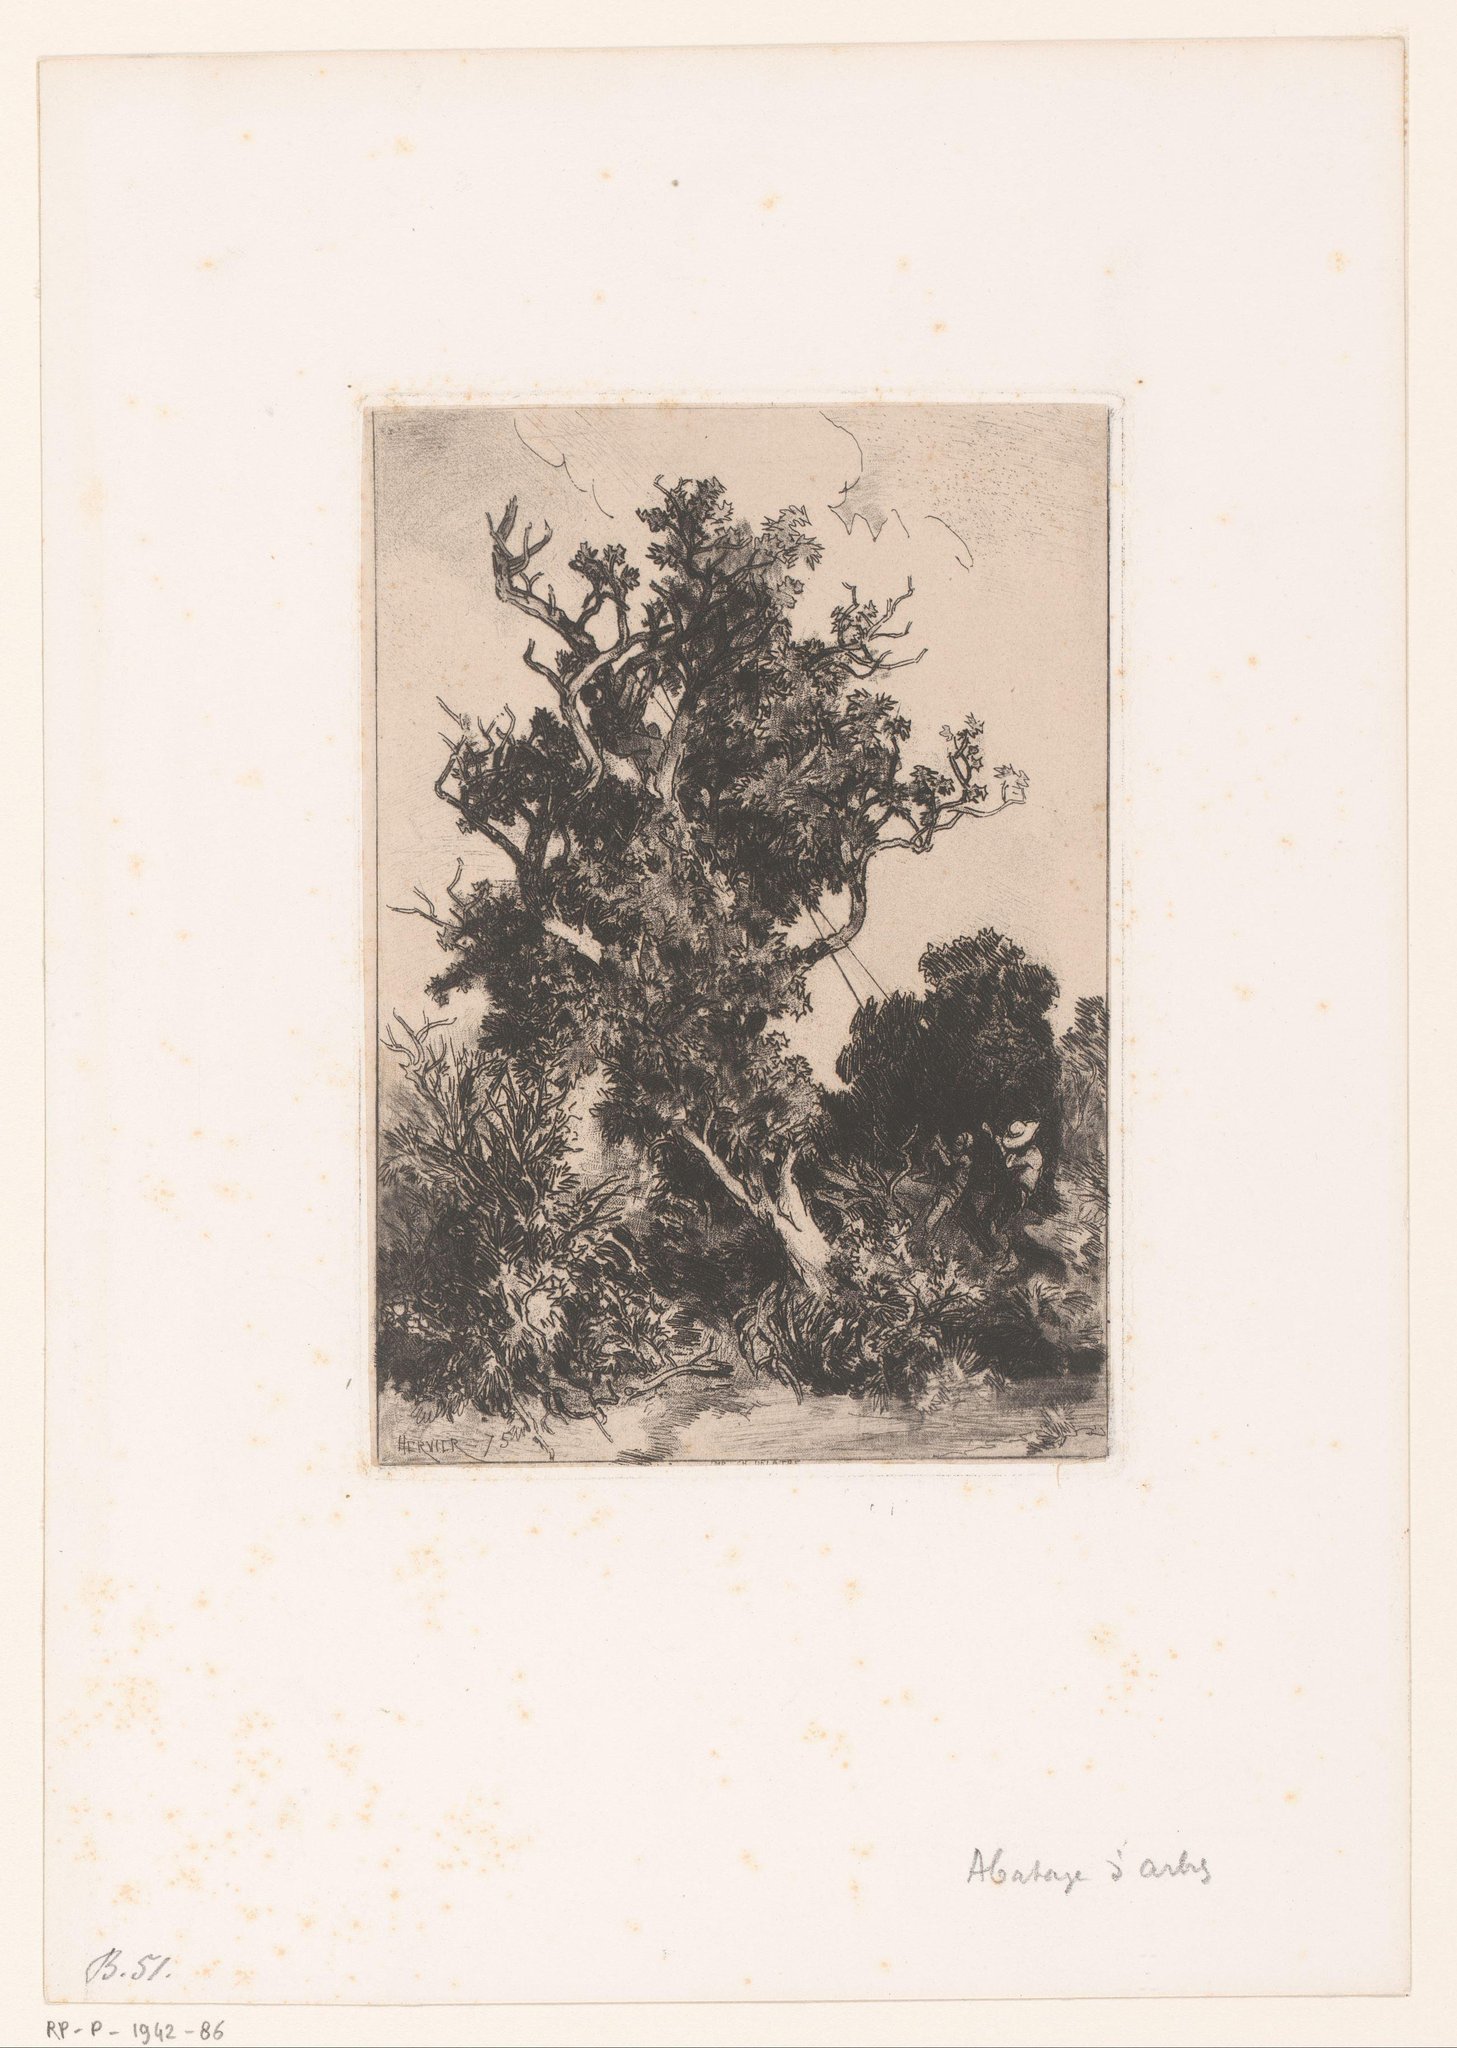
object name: print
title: 6 Eaux-fortes par Hervier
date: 1875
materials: paper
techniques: etching, roulette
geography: paris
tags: trees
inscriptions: collector's mark: Lugt 2228, collector's mark: Lugt 2760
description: Maakt deel uit van een zesdelige serie prenten met verschillende onderwerpen, samengesteld en uitgevoerd door Hervier.